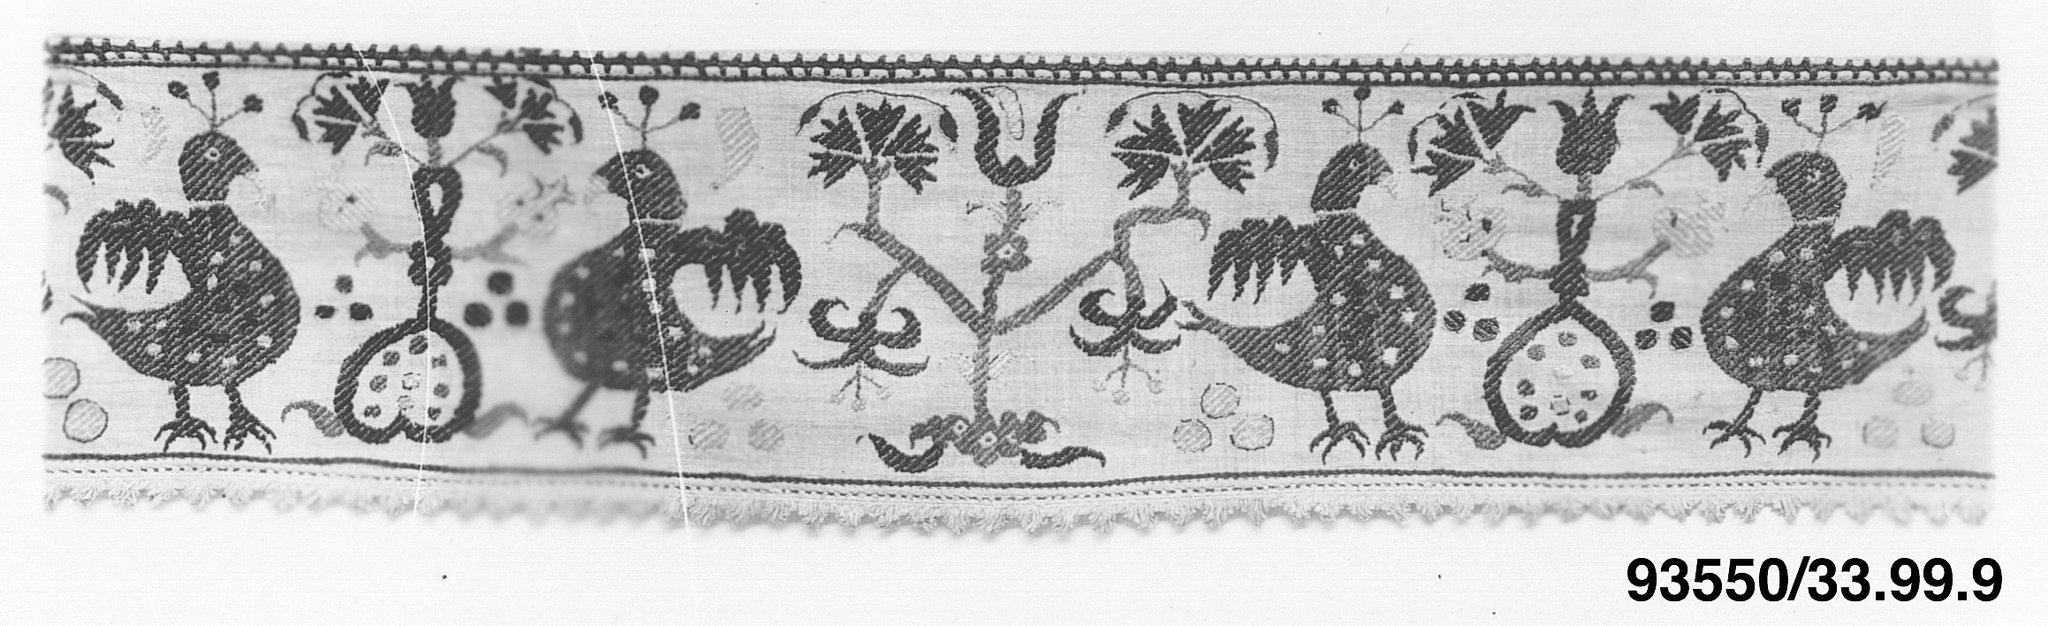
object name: border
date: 1701-1800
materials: linen, silk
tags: birds